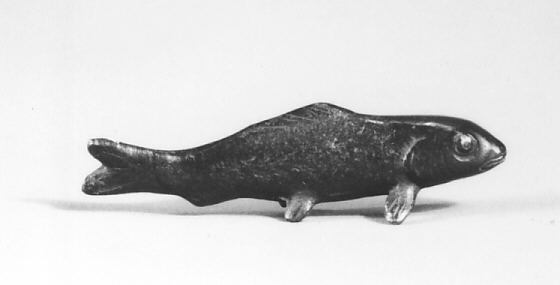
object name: figurine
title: Fish Figurine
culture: japanese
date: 1901-2000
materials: bronze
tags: fish